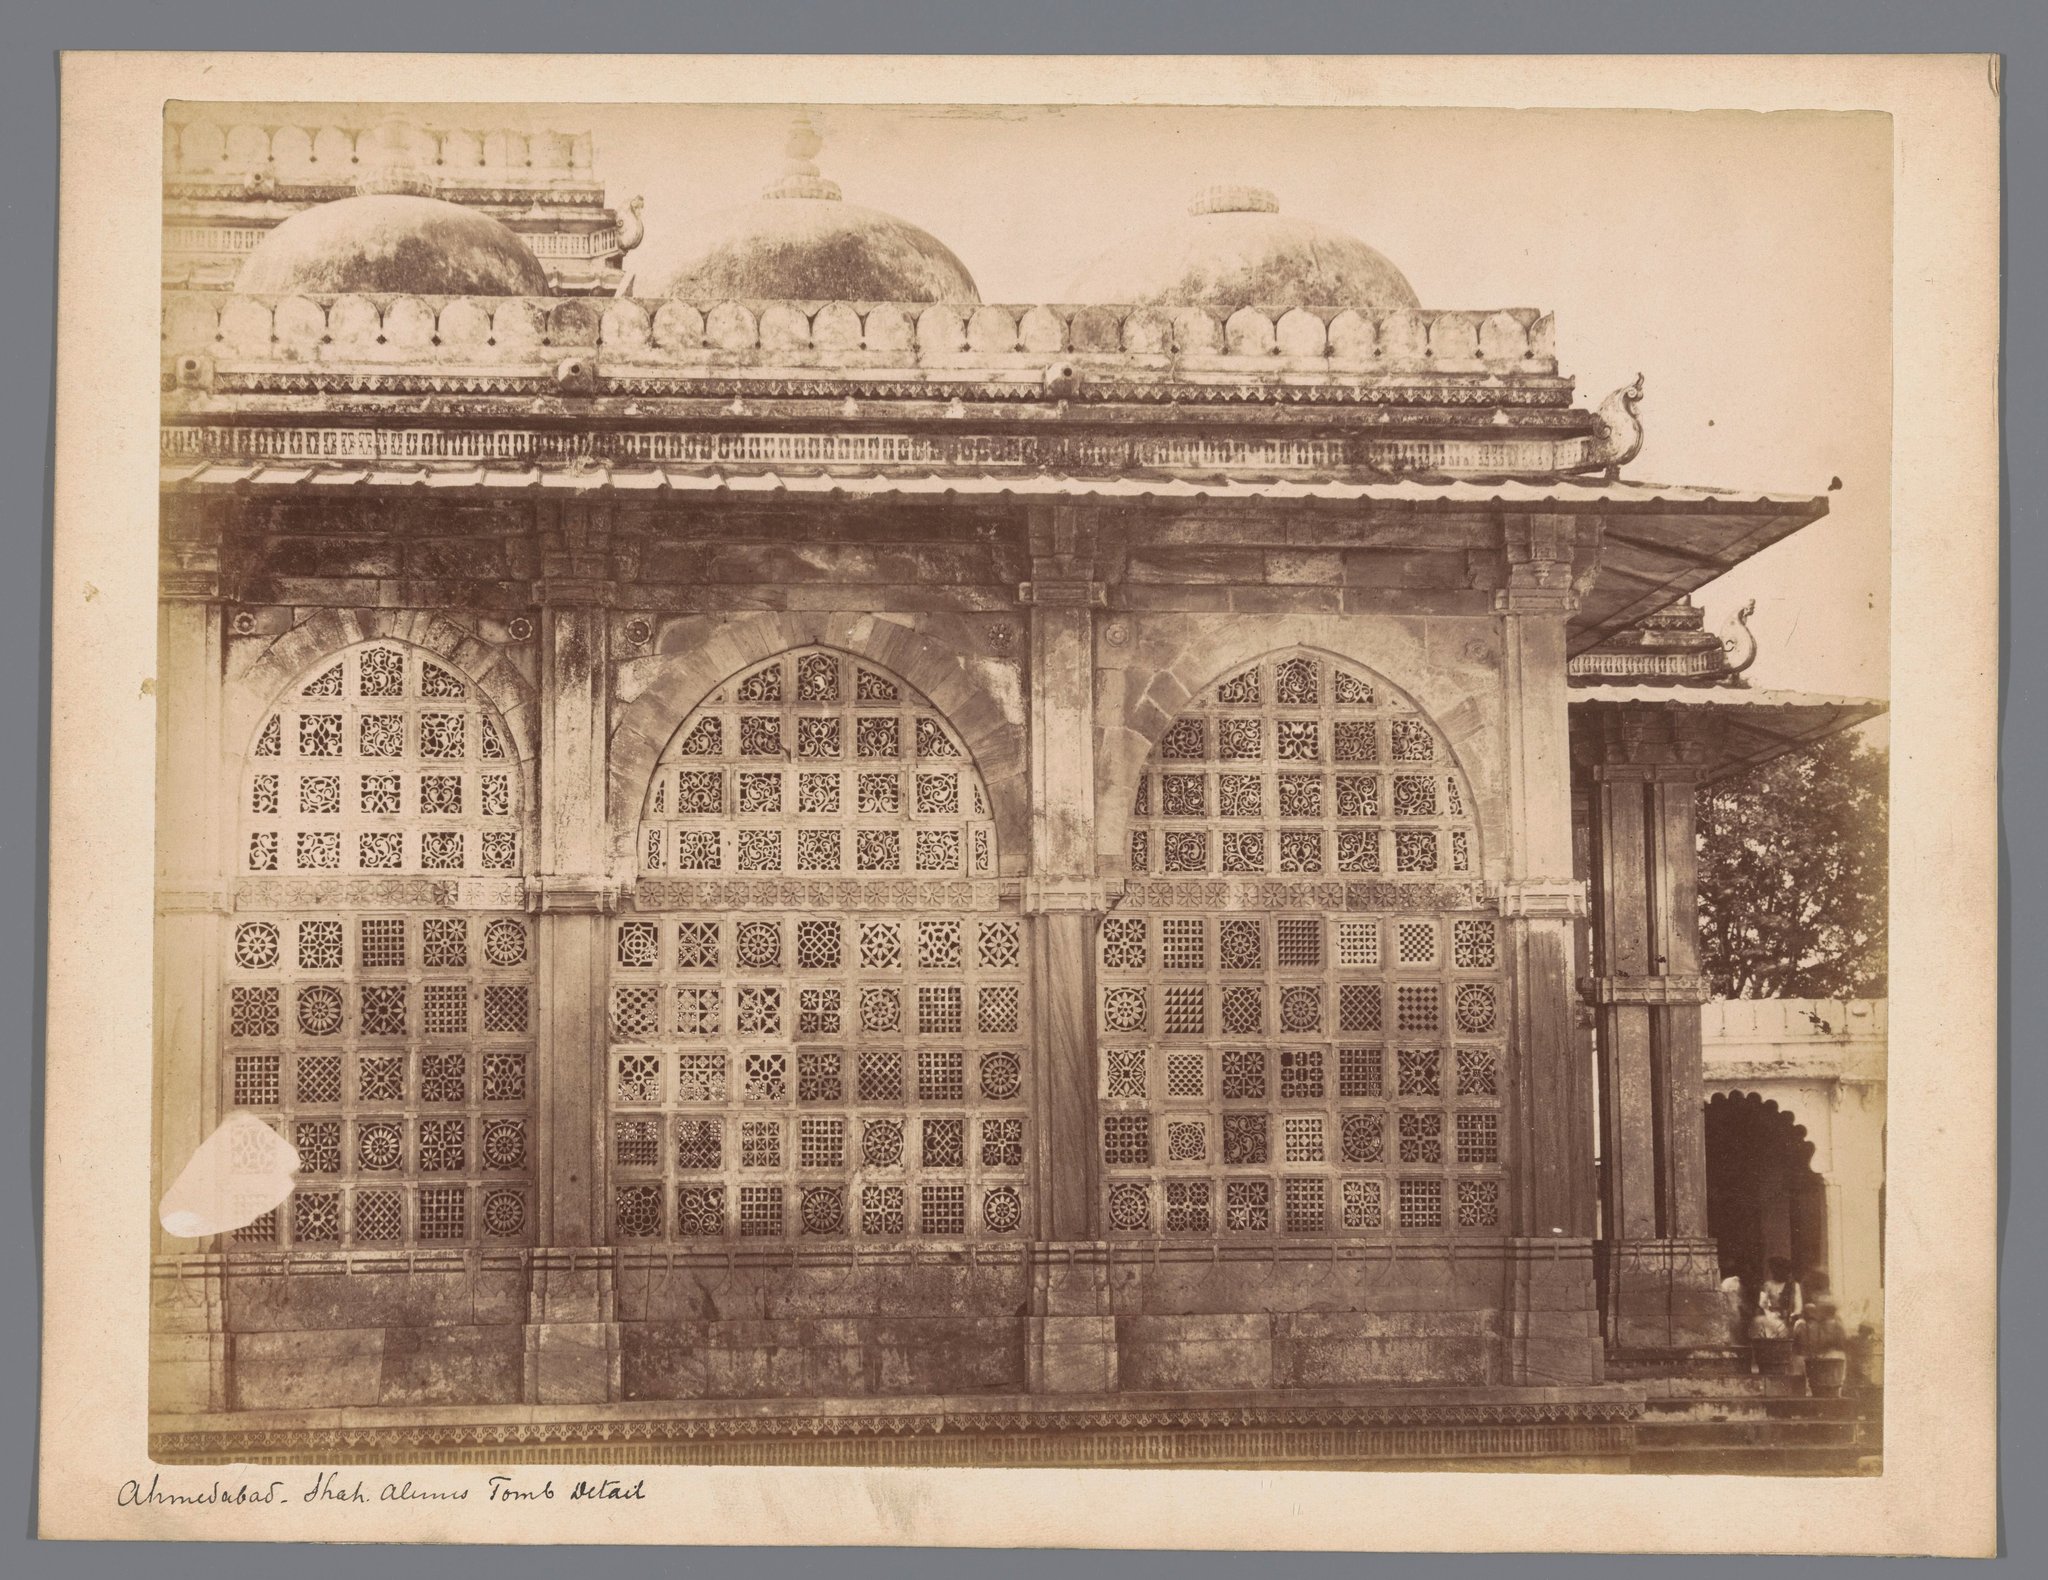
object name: photograph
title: Detail of Shah-e-Alam Roza in Ahmedabad, Gujarat, India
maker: Anonymous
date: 1865-1890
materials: cardboard, paper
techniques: albumen print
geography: ahmedabad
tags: mausoleum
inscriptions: number: ‘15’, title: ‘Ahmedabad - Shah Alums Tomb Detail’